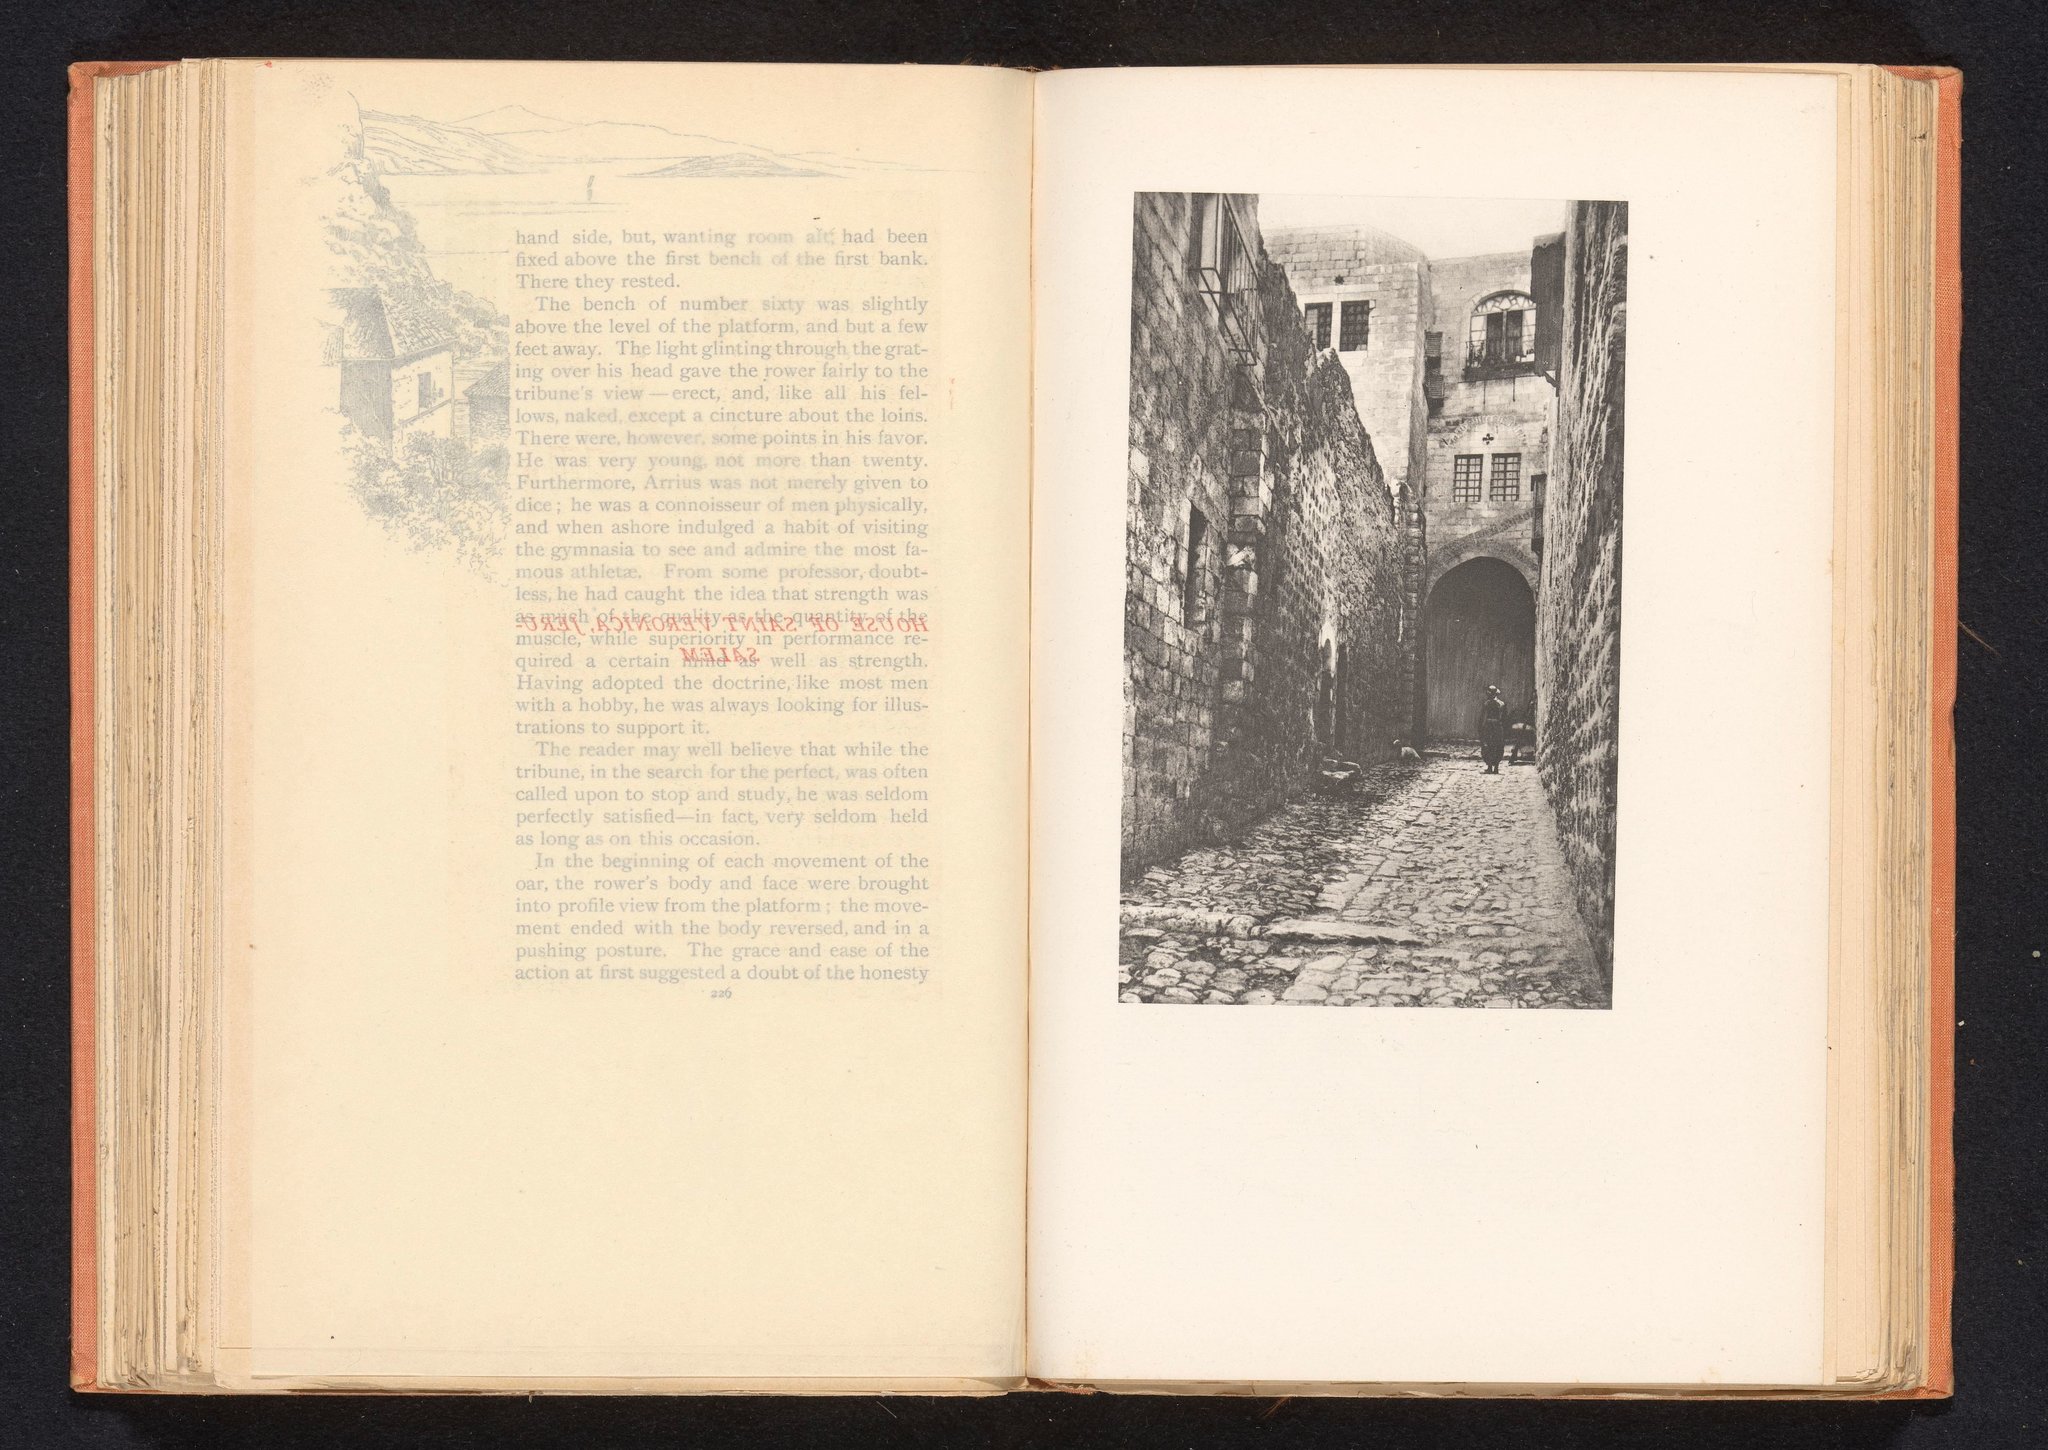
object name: photomechanical print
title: House of Saint Veronica, Jeruzalem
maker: Anonymous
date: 1882-1892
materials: paper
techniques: photoaquatint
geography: jerusalem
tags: street